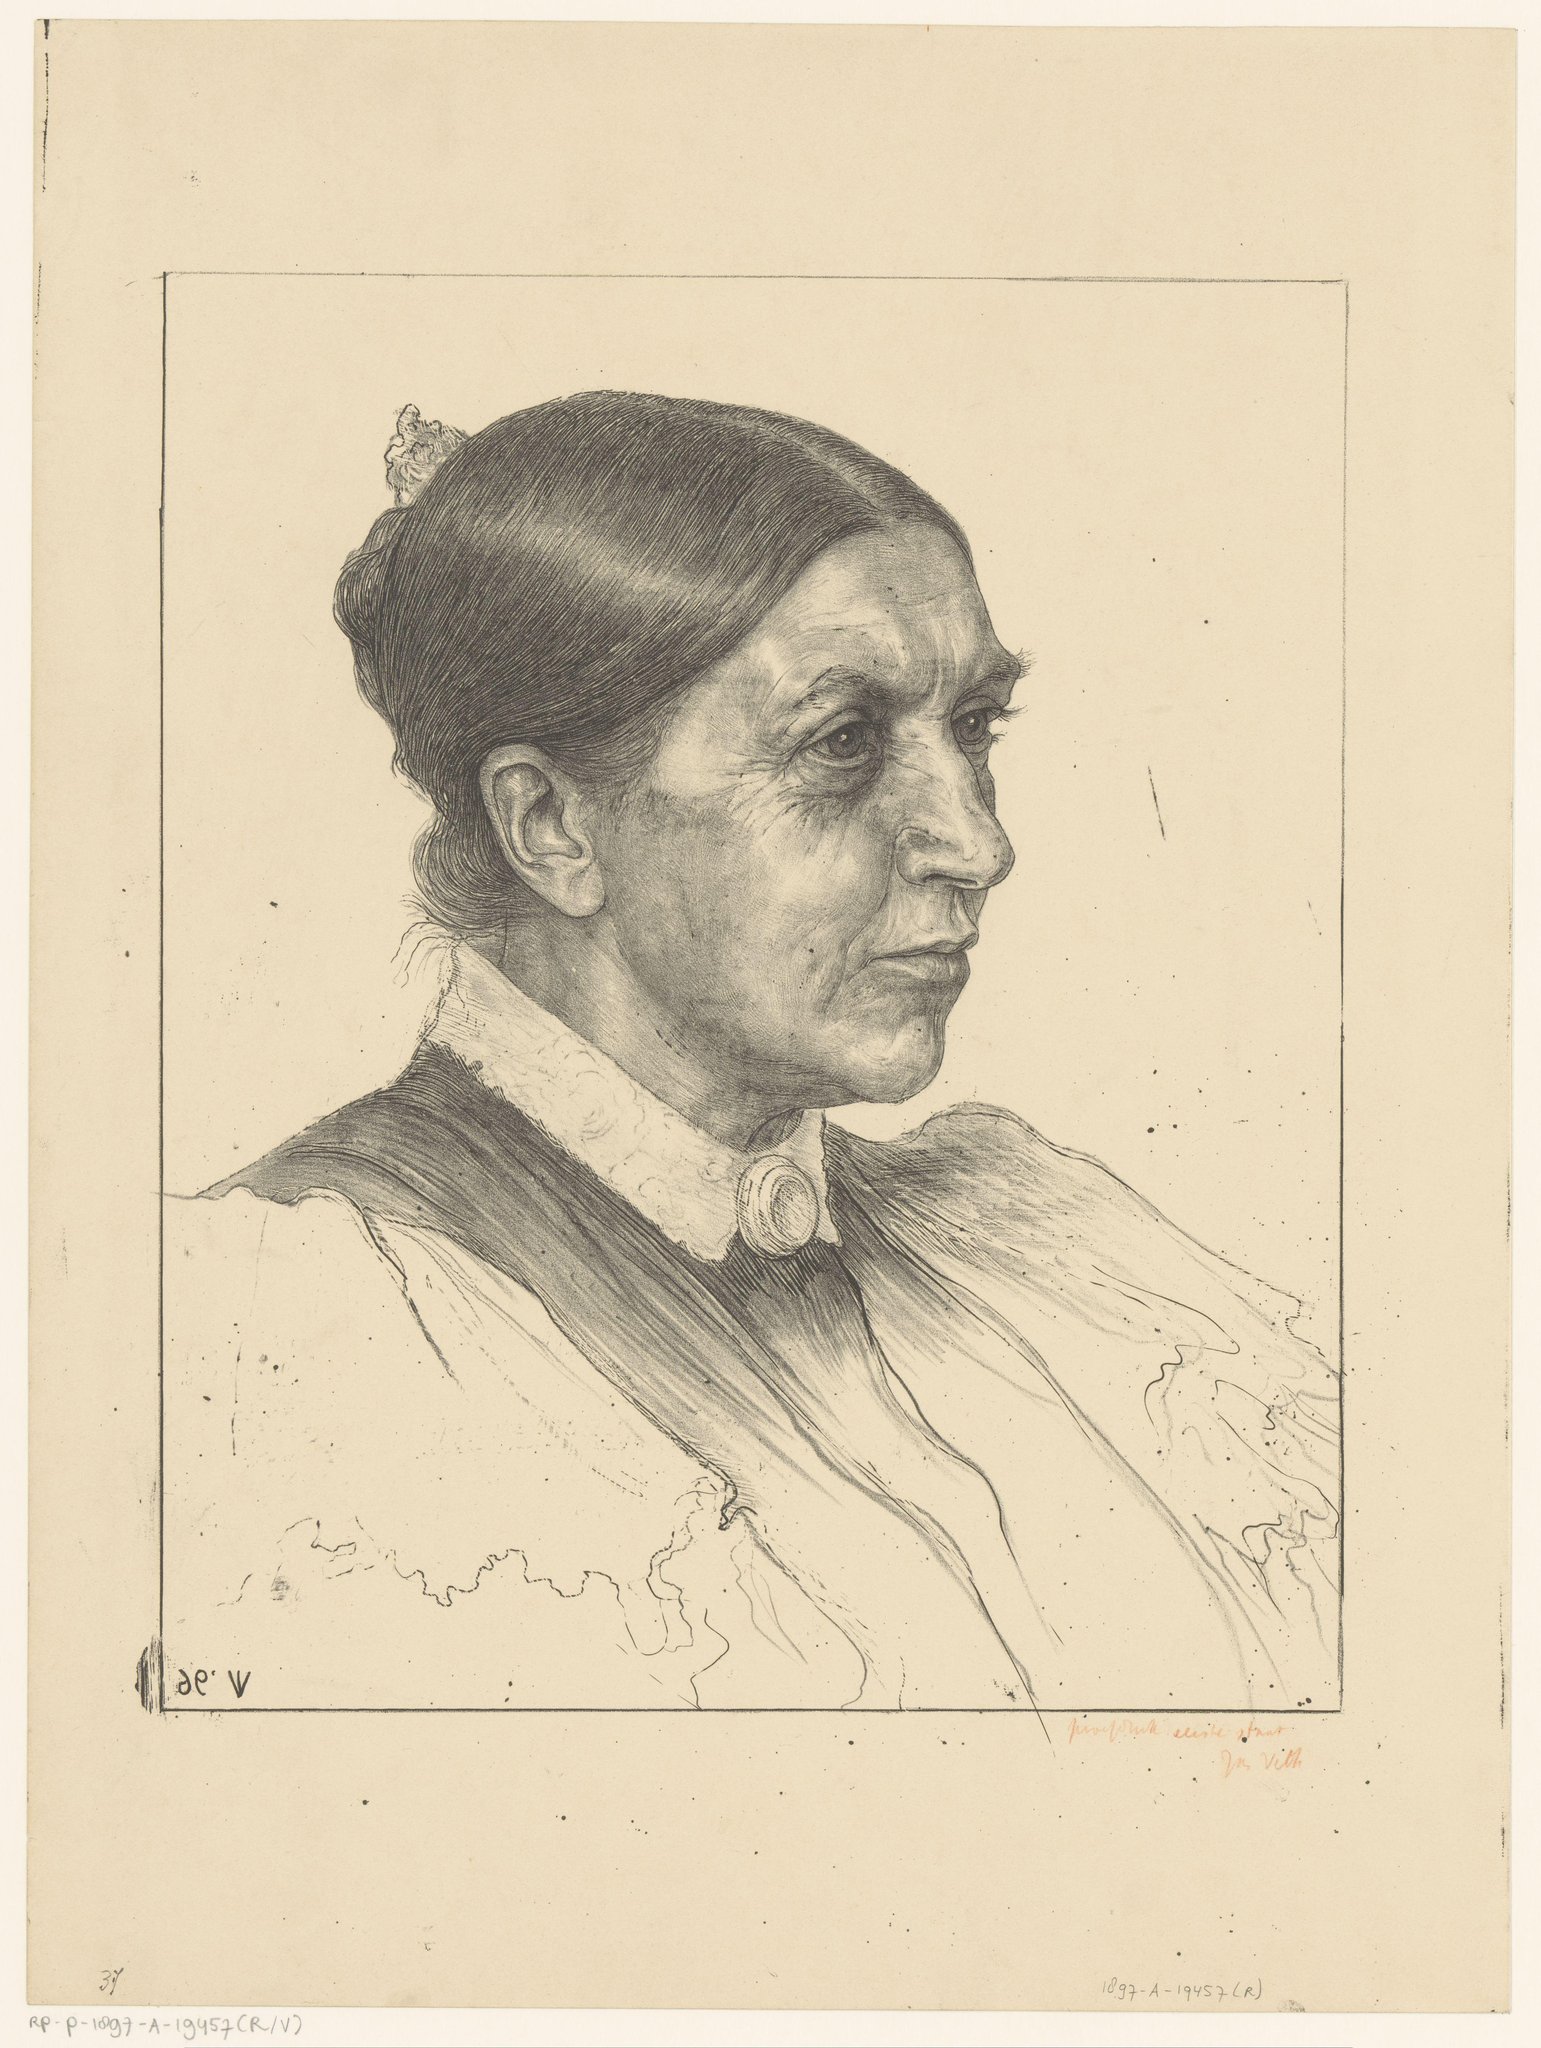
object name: print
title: Bekende tijdgenooten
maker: jan veth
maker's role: designer, draughtsman, painter, print maker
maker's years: 1864-1925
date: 1896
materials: paper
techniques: lithograph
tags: amsterdam, historical persons - bb - woman (+ (full) bust portrait)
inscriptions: inscription: ‘Proefdruk eerste staat / Jan Veth’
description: Deze prent werd uitgegeven door De Amsterdammer op 8 november 1896.